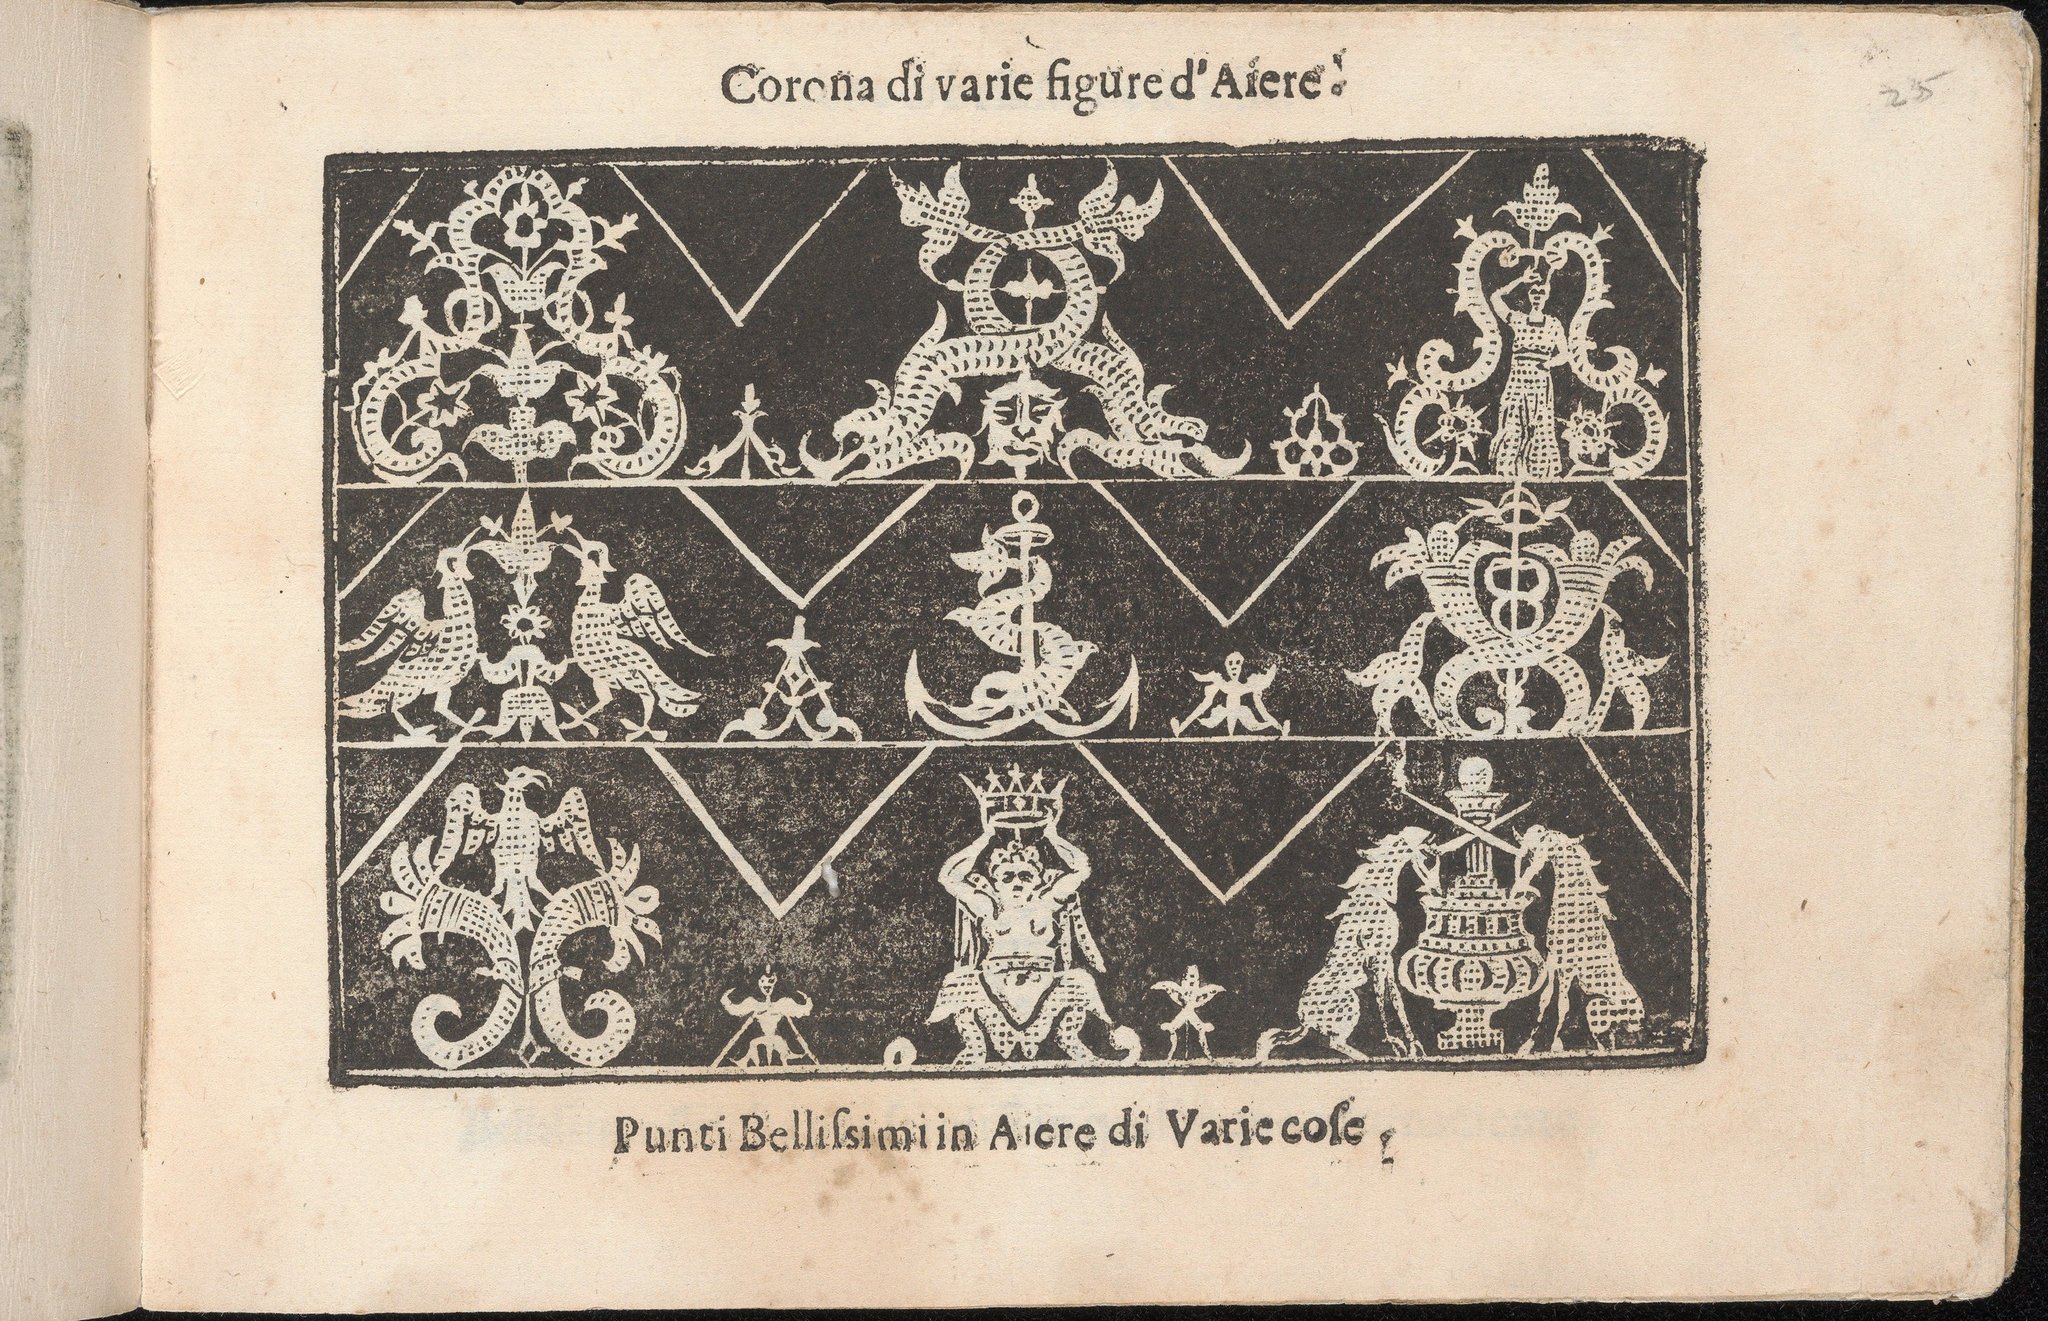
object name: book print ornament architecture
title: Corona delle Nobile et Virtuose Donne, Libro Terzo, page 25 (recto)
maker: cesare vecellio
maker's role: designer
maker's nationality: italian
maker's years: 1521-1601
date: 1620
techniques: woodcut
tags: birds,ornament,unicorns